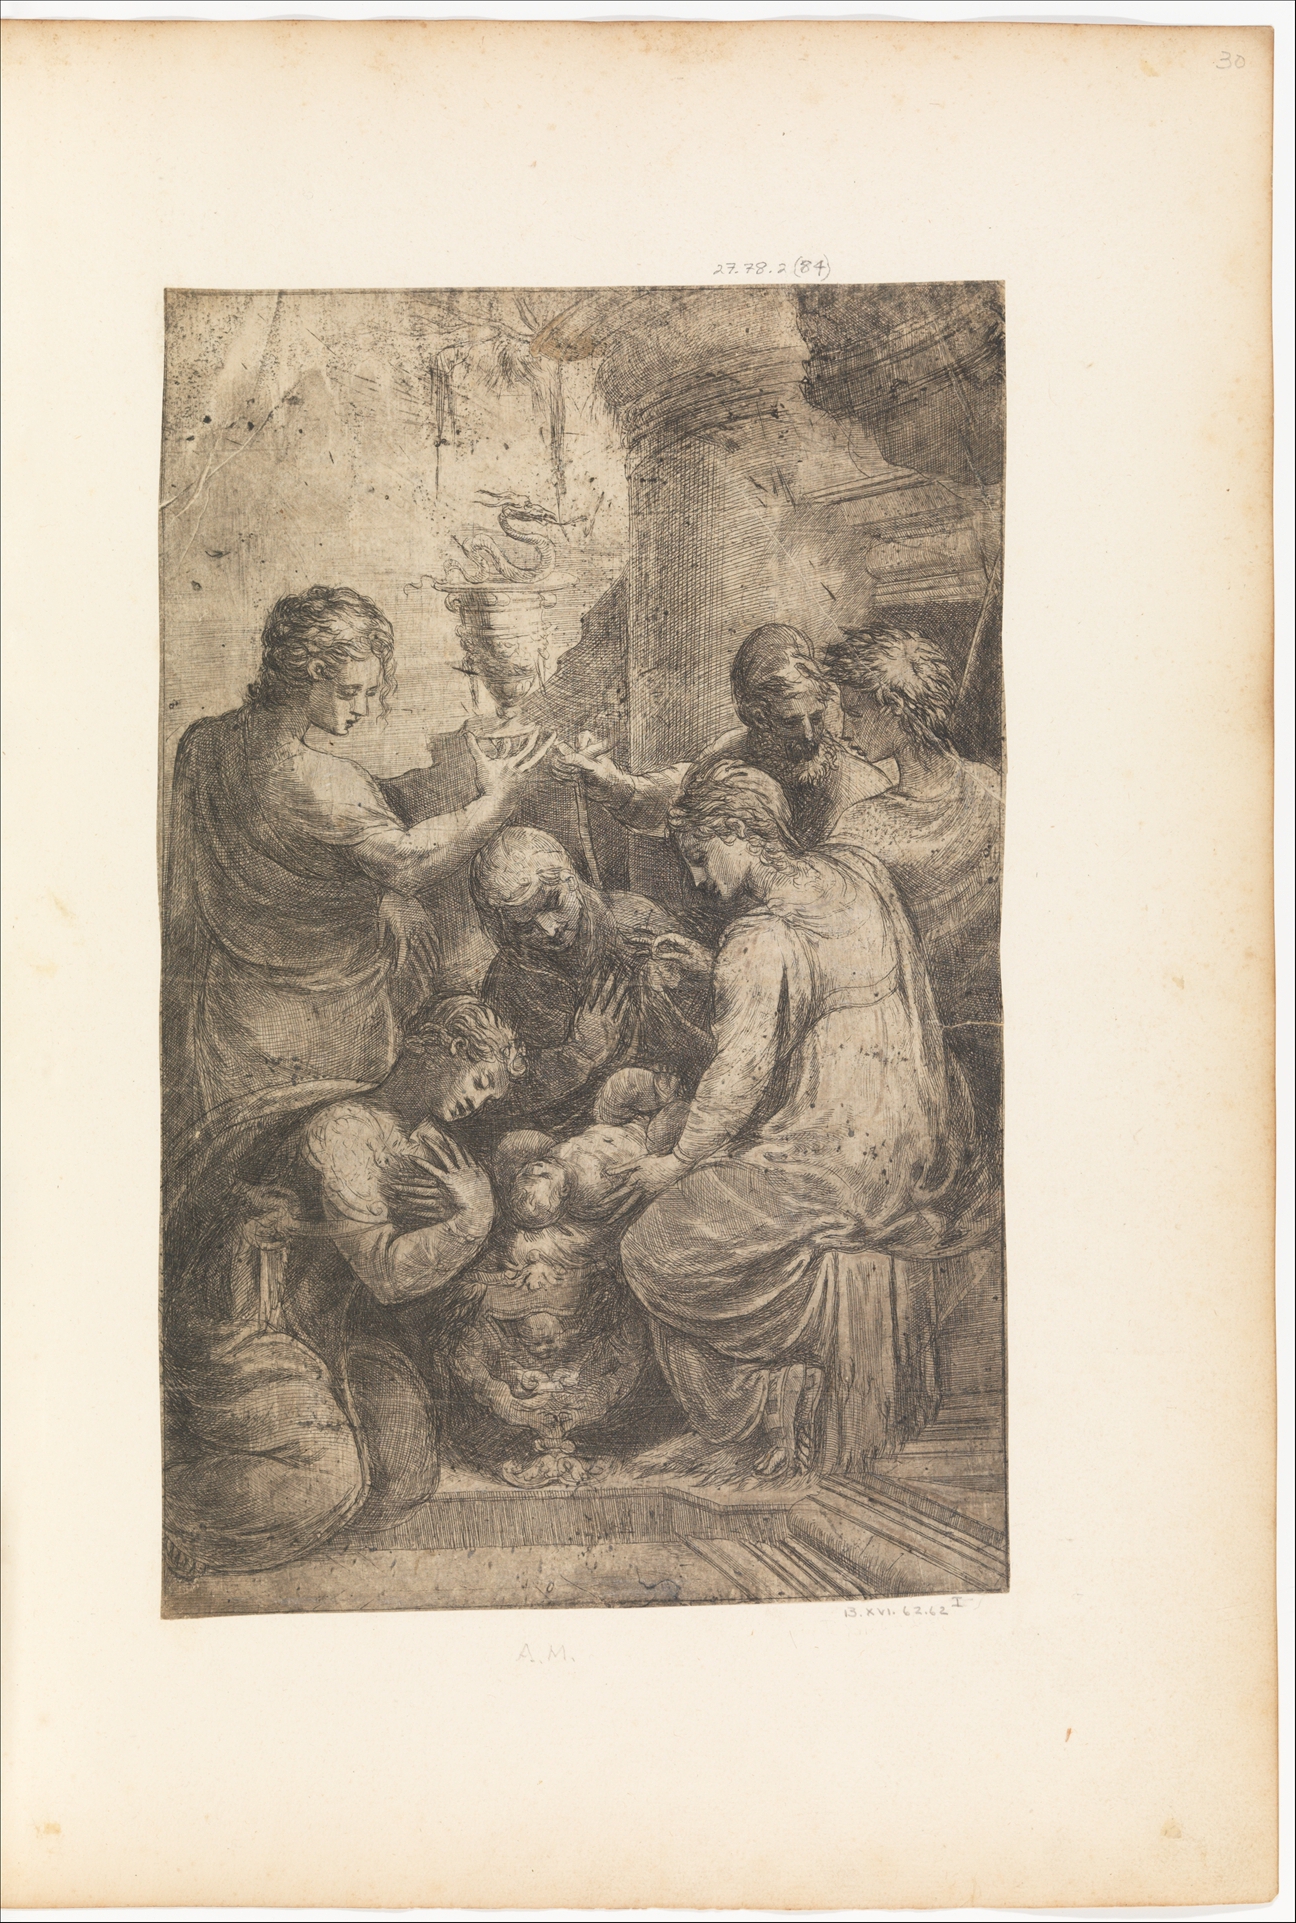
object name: print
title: Adoration of the Child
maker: andrea schiavone (andrea meldola)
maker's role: artist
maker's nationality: italian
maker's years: 1510-1563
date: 1550-1555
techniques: etching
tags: infants,women,christ